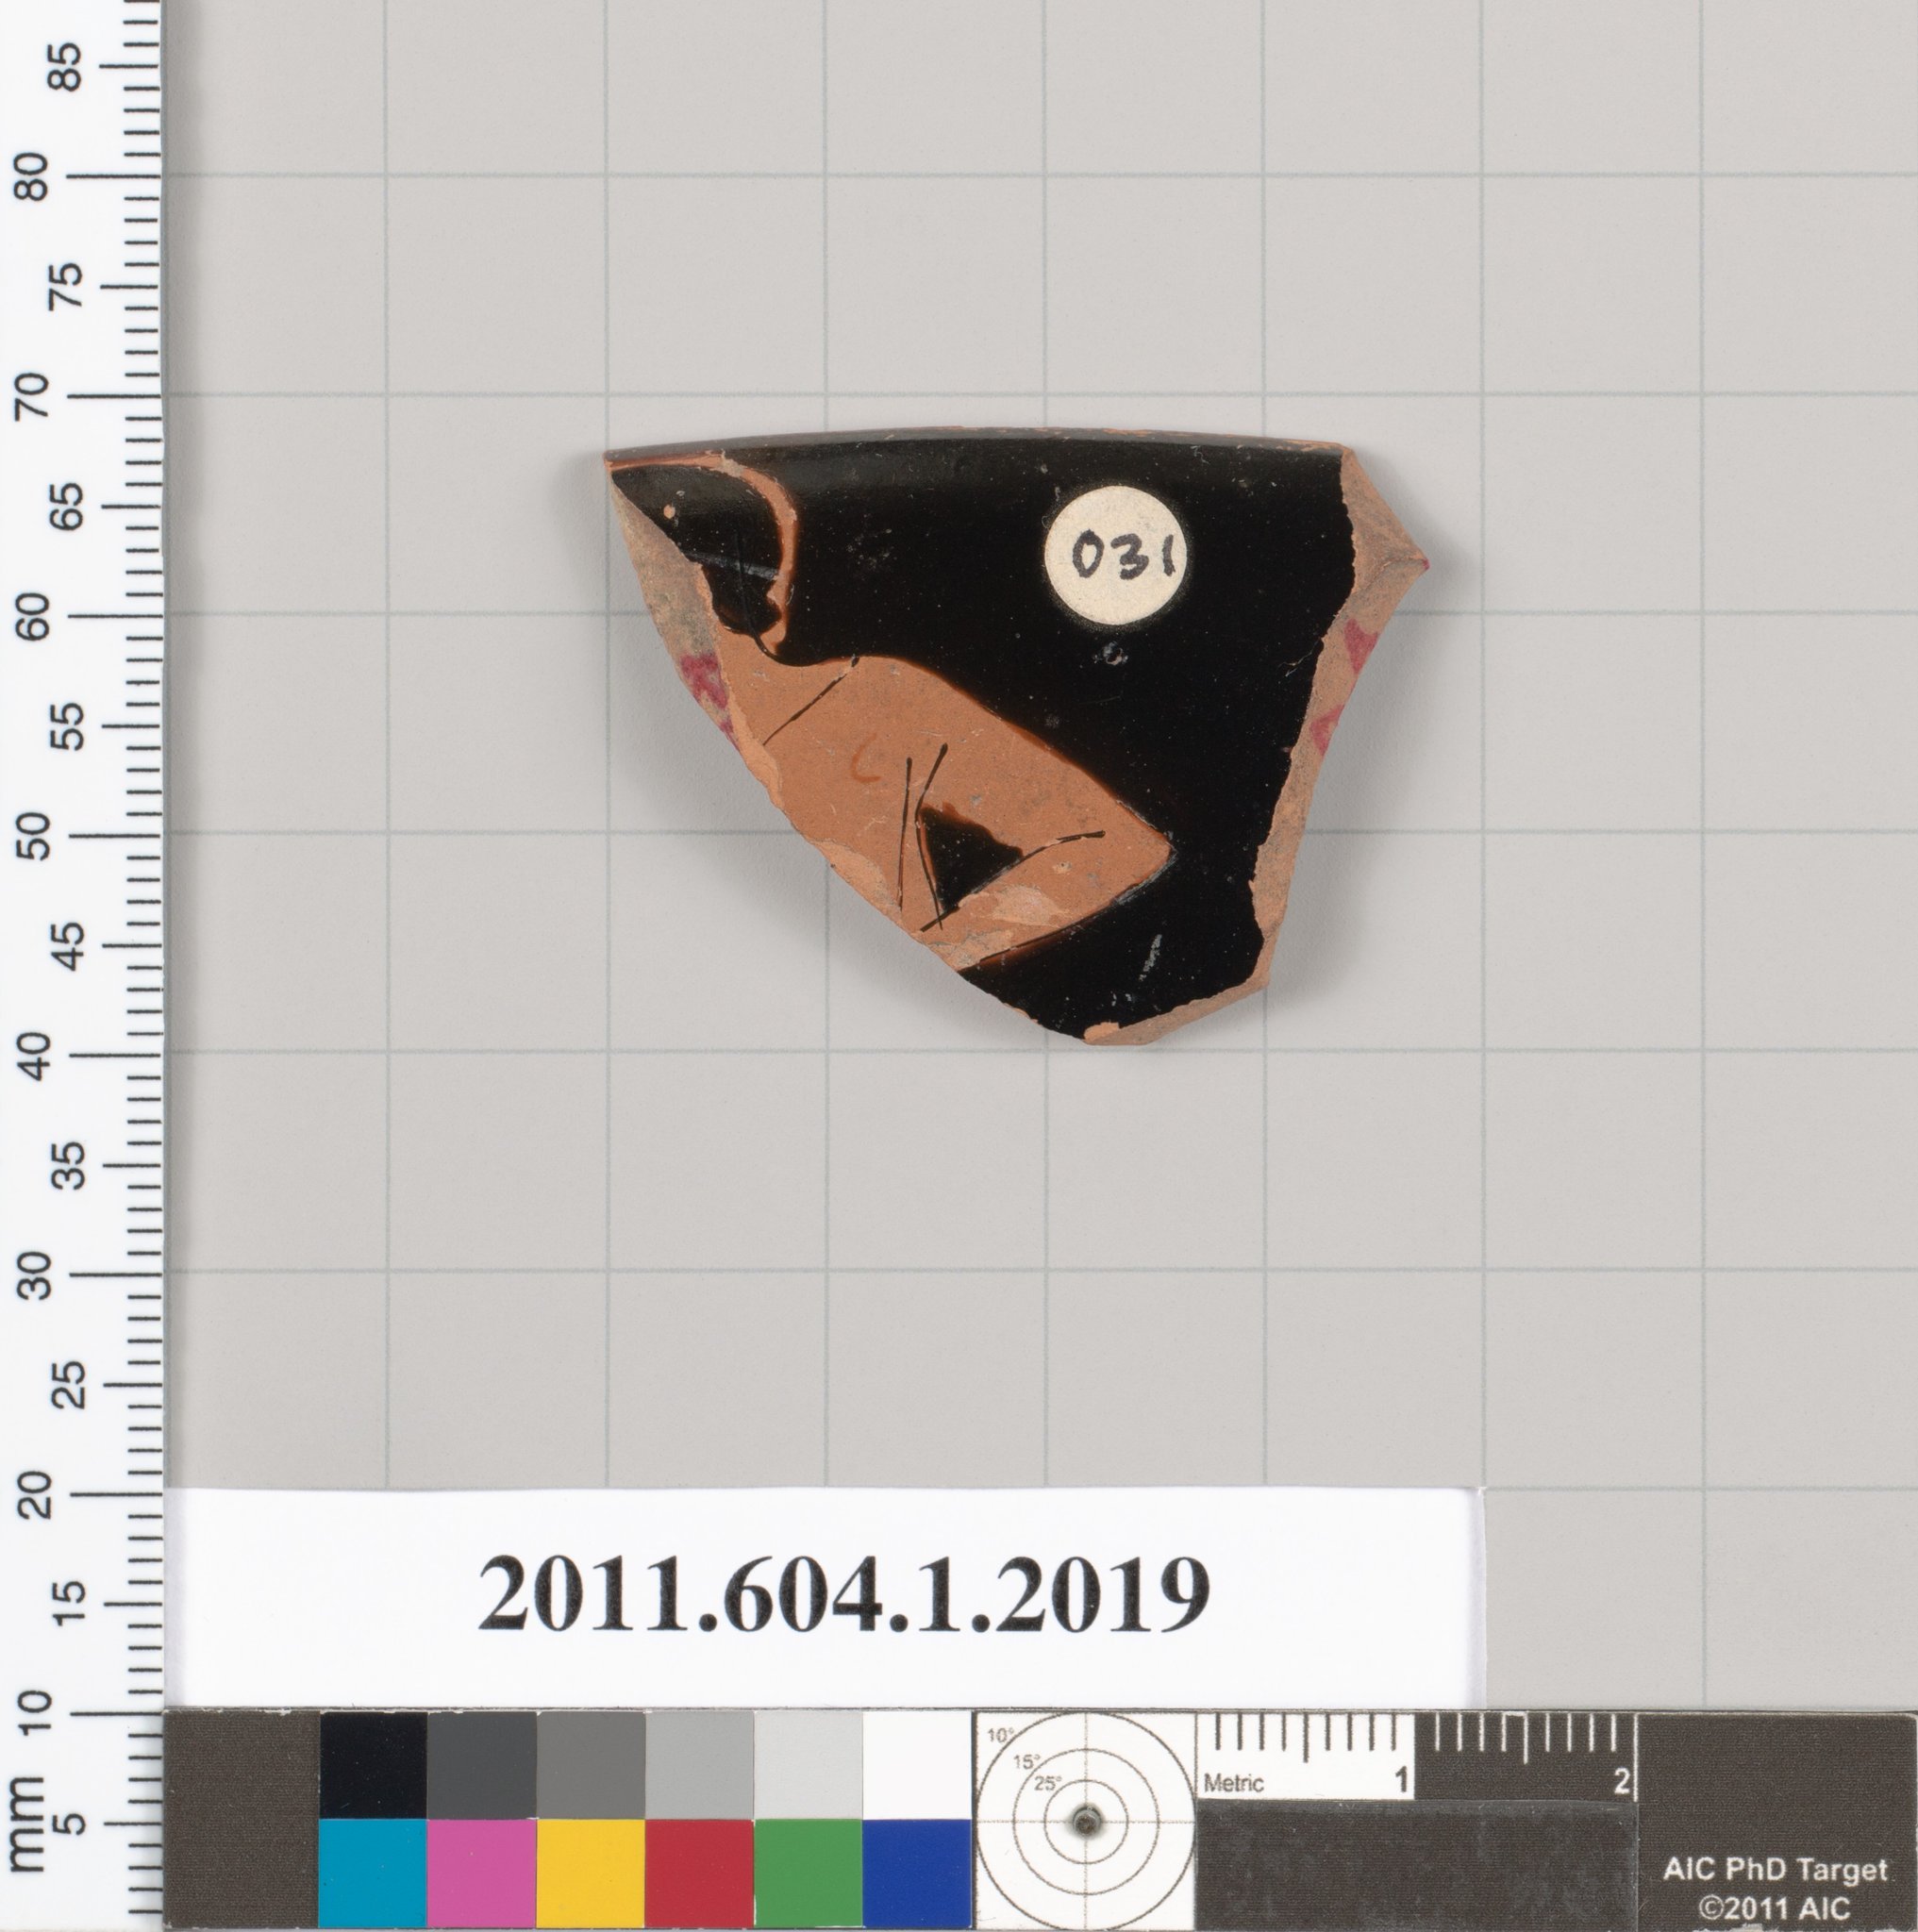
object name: kylix fragment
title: Terracotta rim fragment of a kylix (drinking cup)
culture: greek, attic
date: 475-451 BCE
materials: terracotta